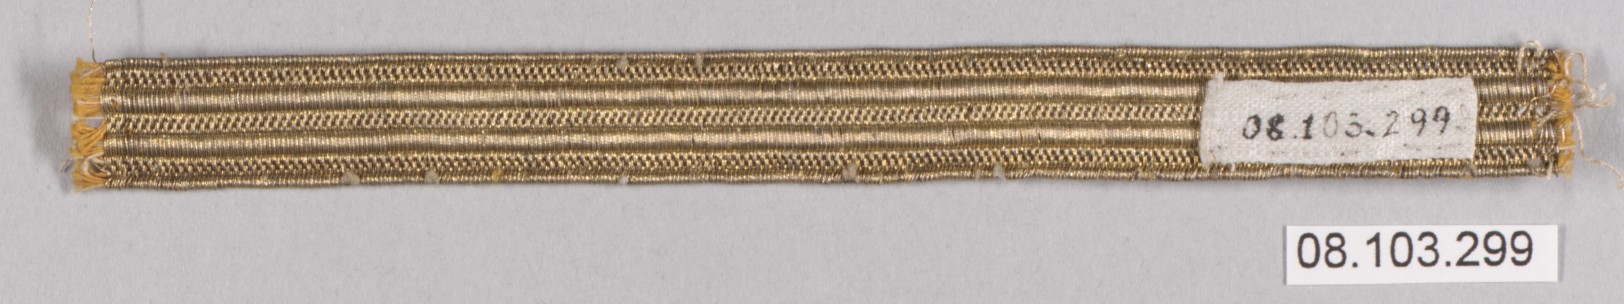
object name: galloon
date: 1601-1800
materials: metal thread